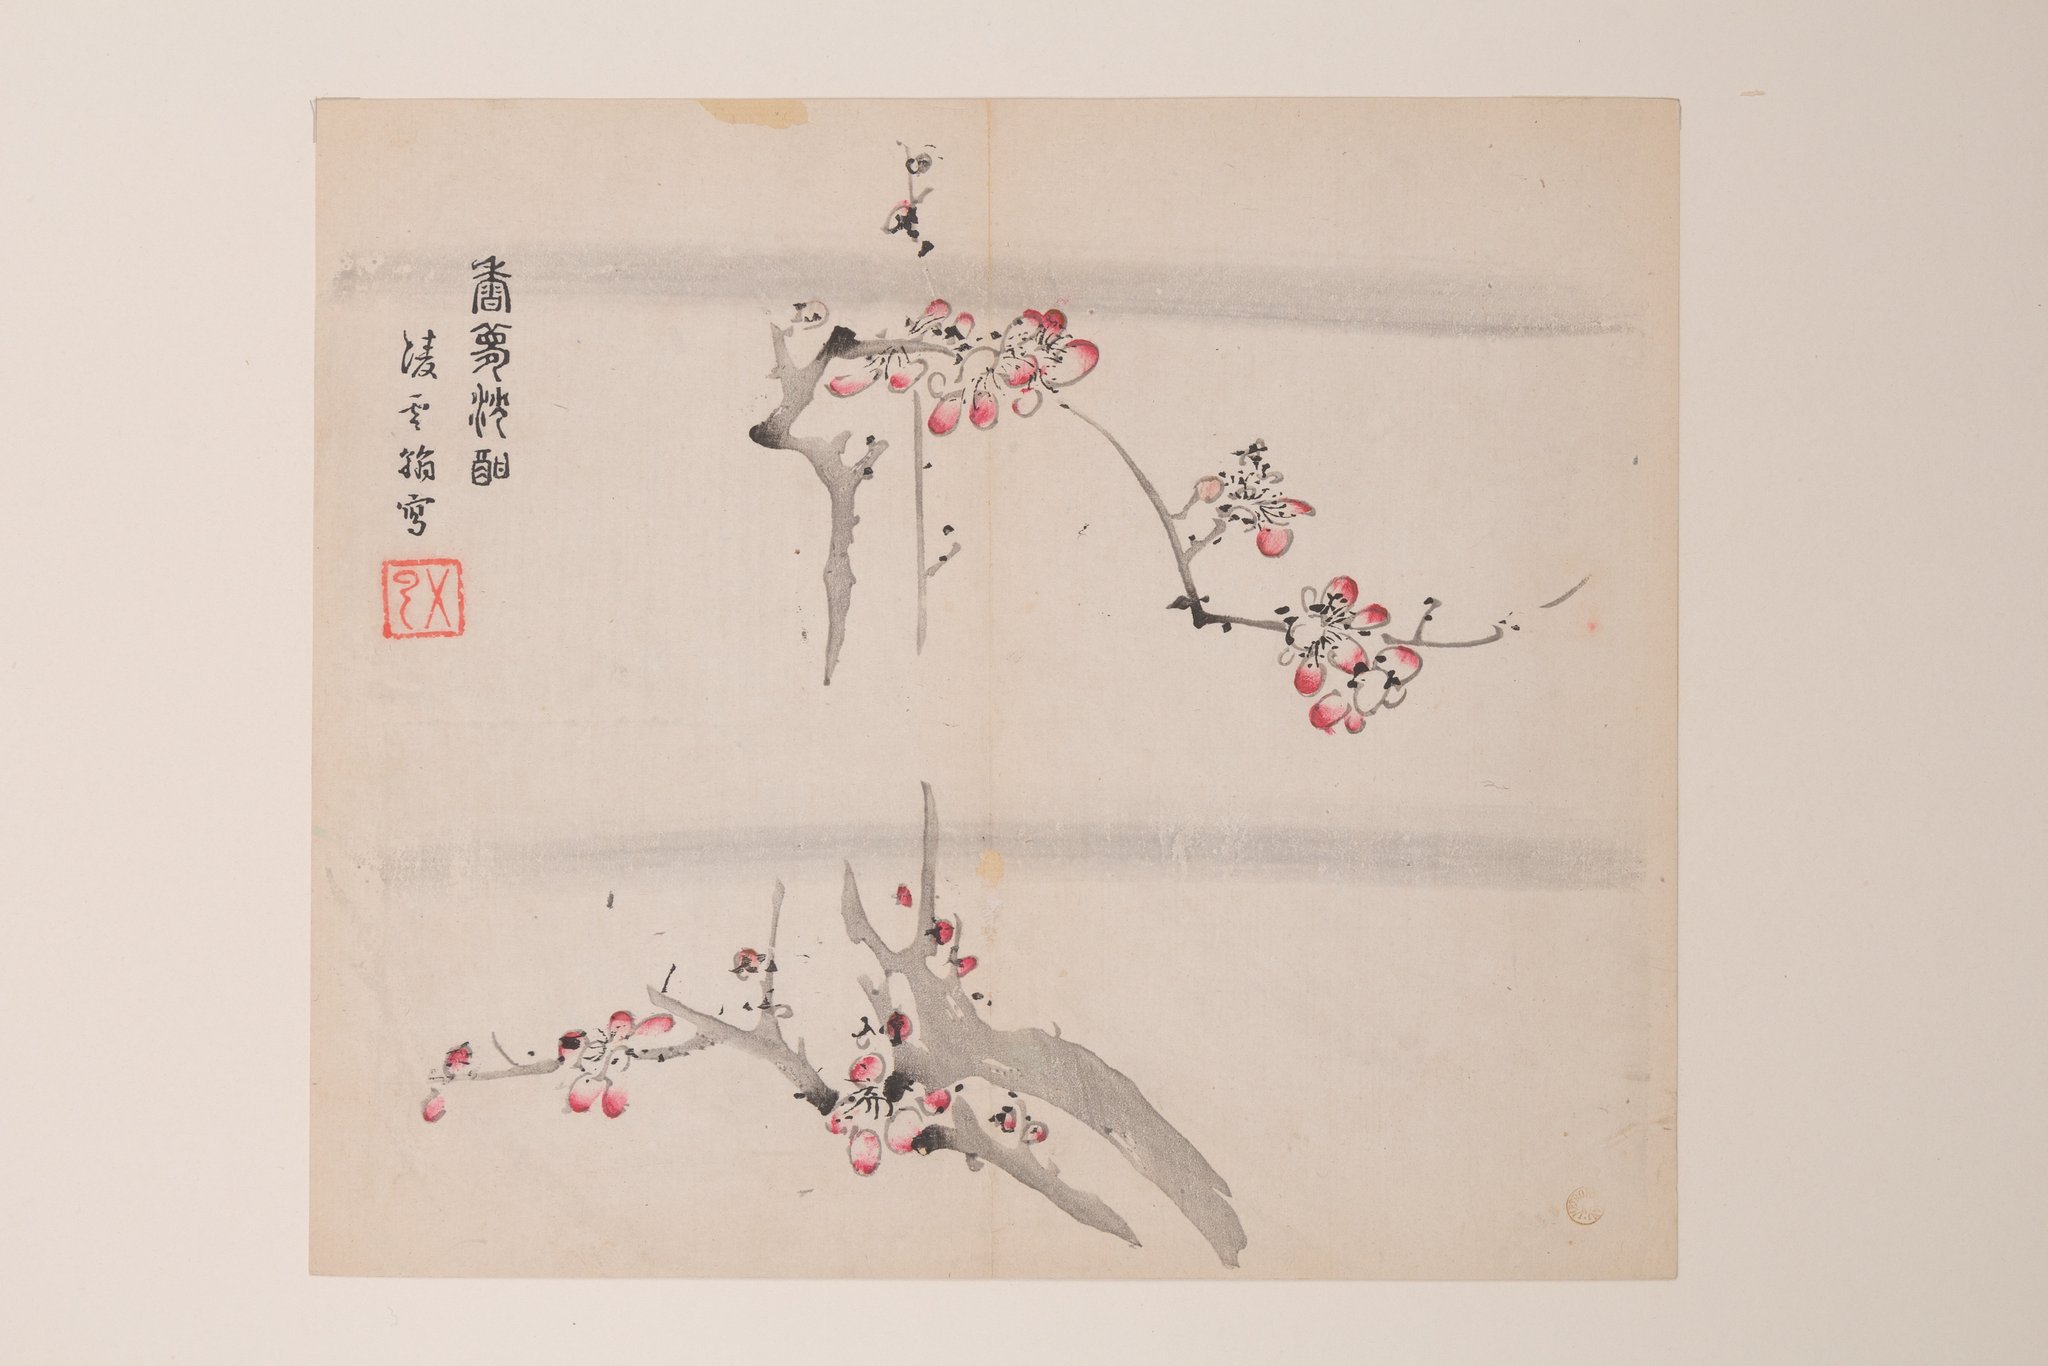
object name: print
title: Page from the Ten Bamboo Studio Manual of Painting and Calligraphy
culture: chinese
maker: hu zhengyan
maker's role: artist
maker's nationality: chinese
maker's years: 1584-1634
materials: ink, paper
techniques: printing